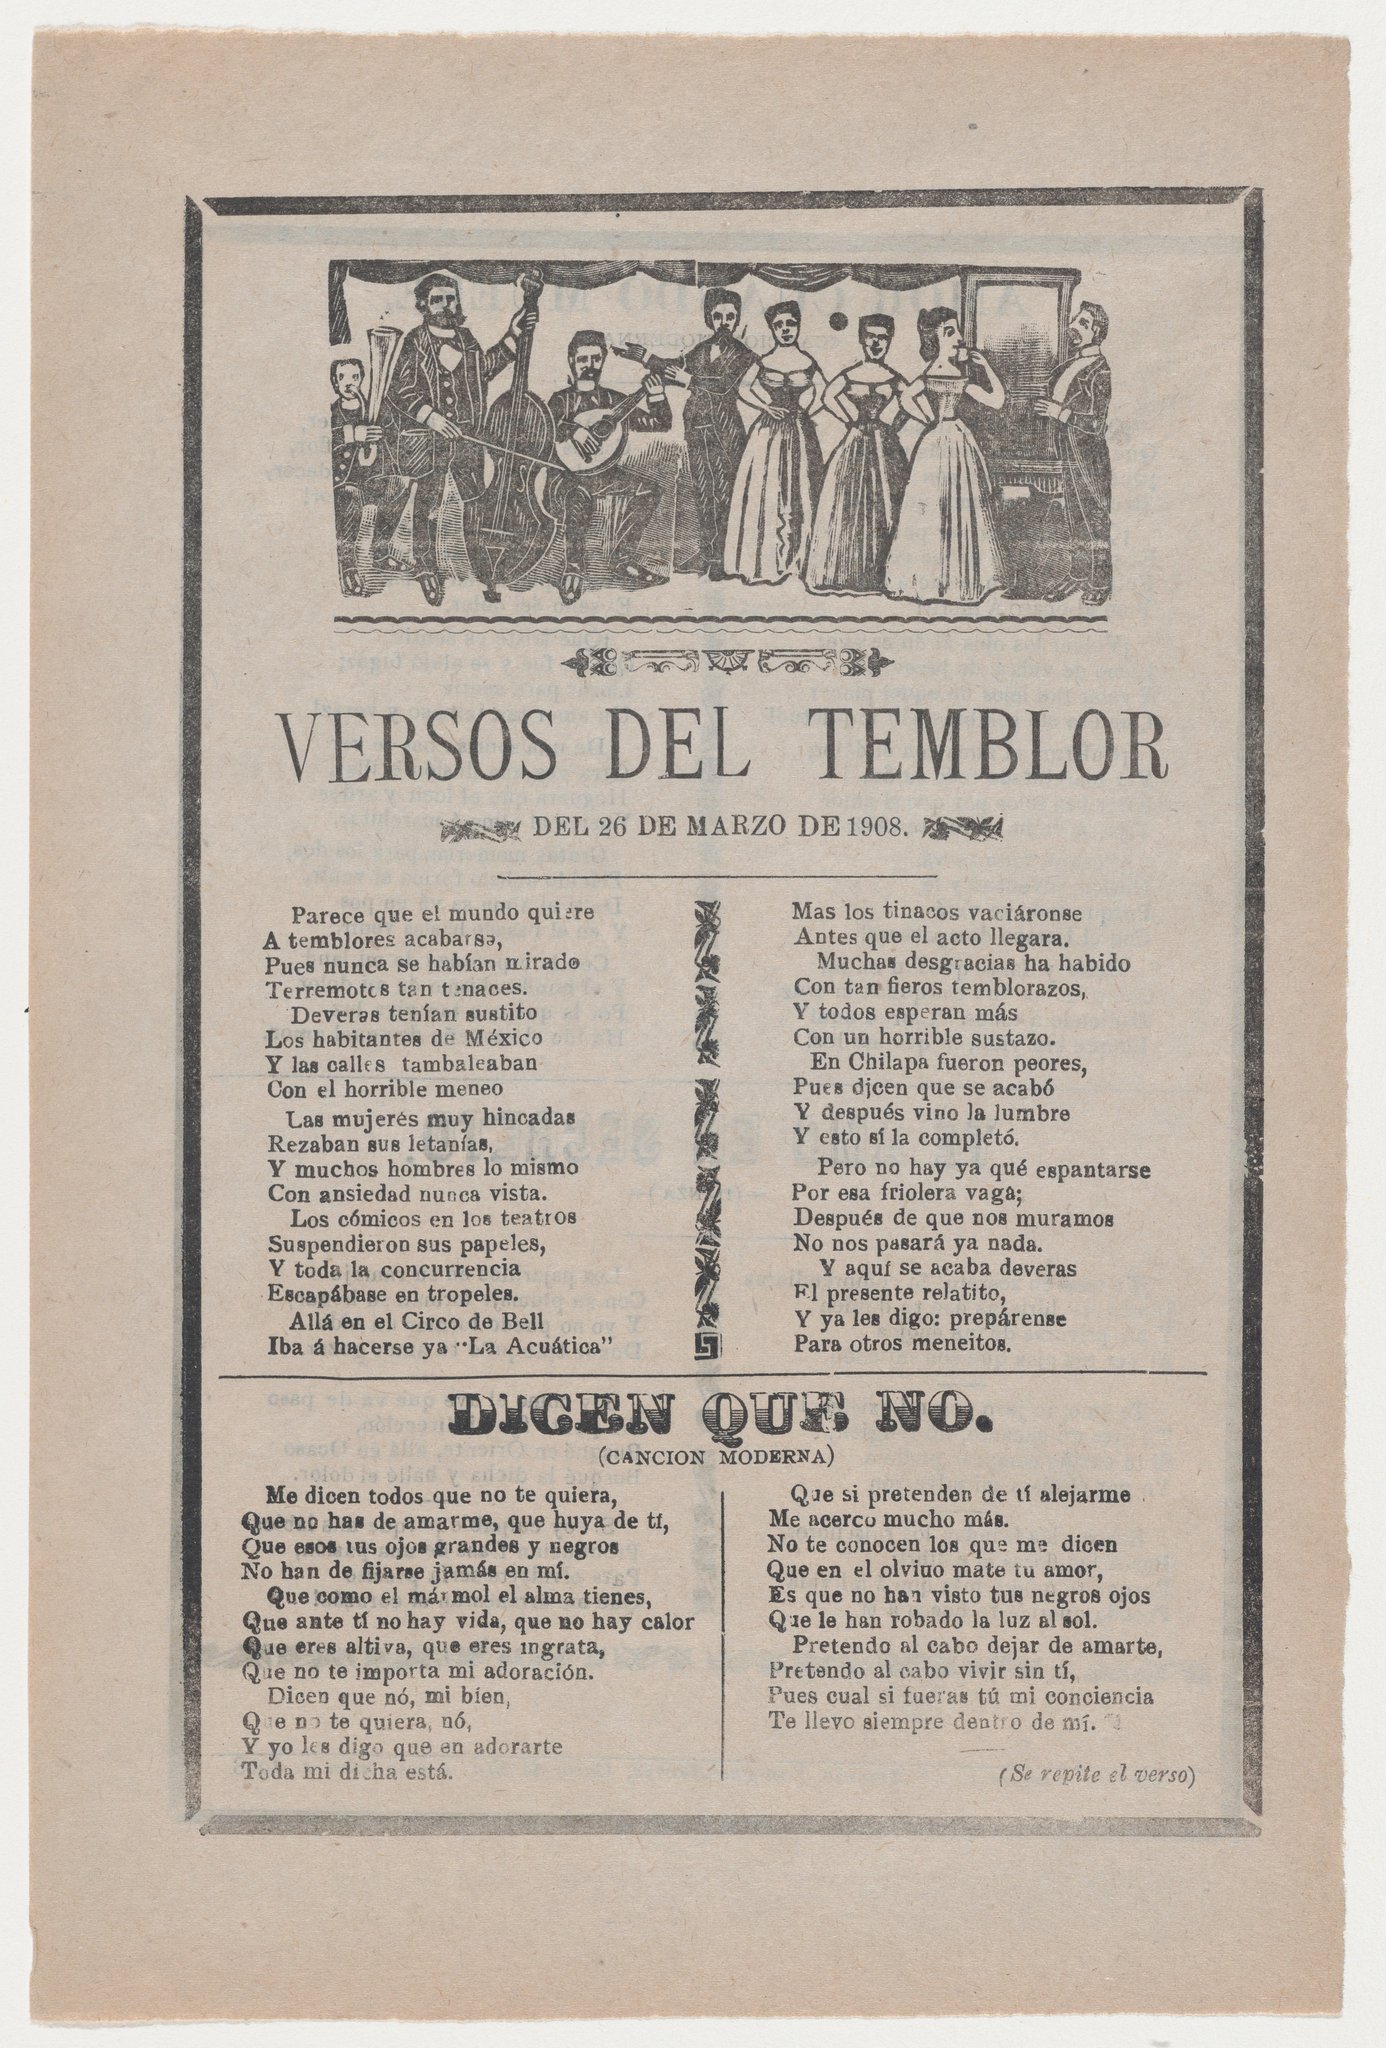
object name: print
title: Broadsheet with songs relating to the earthquake that occurred on March 26, 1908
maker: josé guadalupe posada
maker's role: artist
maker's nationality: mexican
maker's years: 1852-1913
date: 1908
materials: metal, paper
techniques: engraving, letterpress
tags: men,women